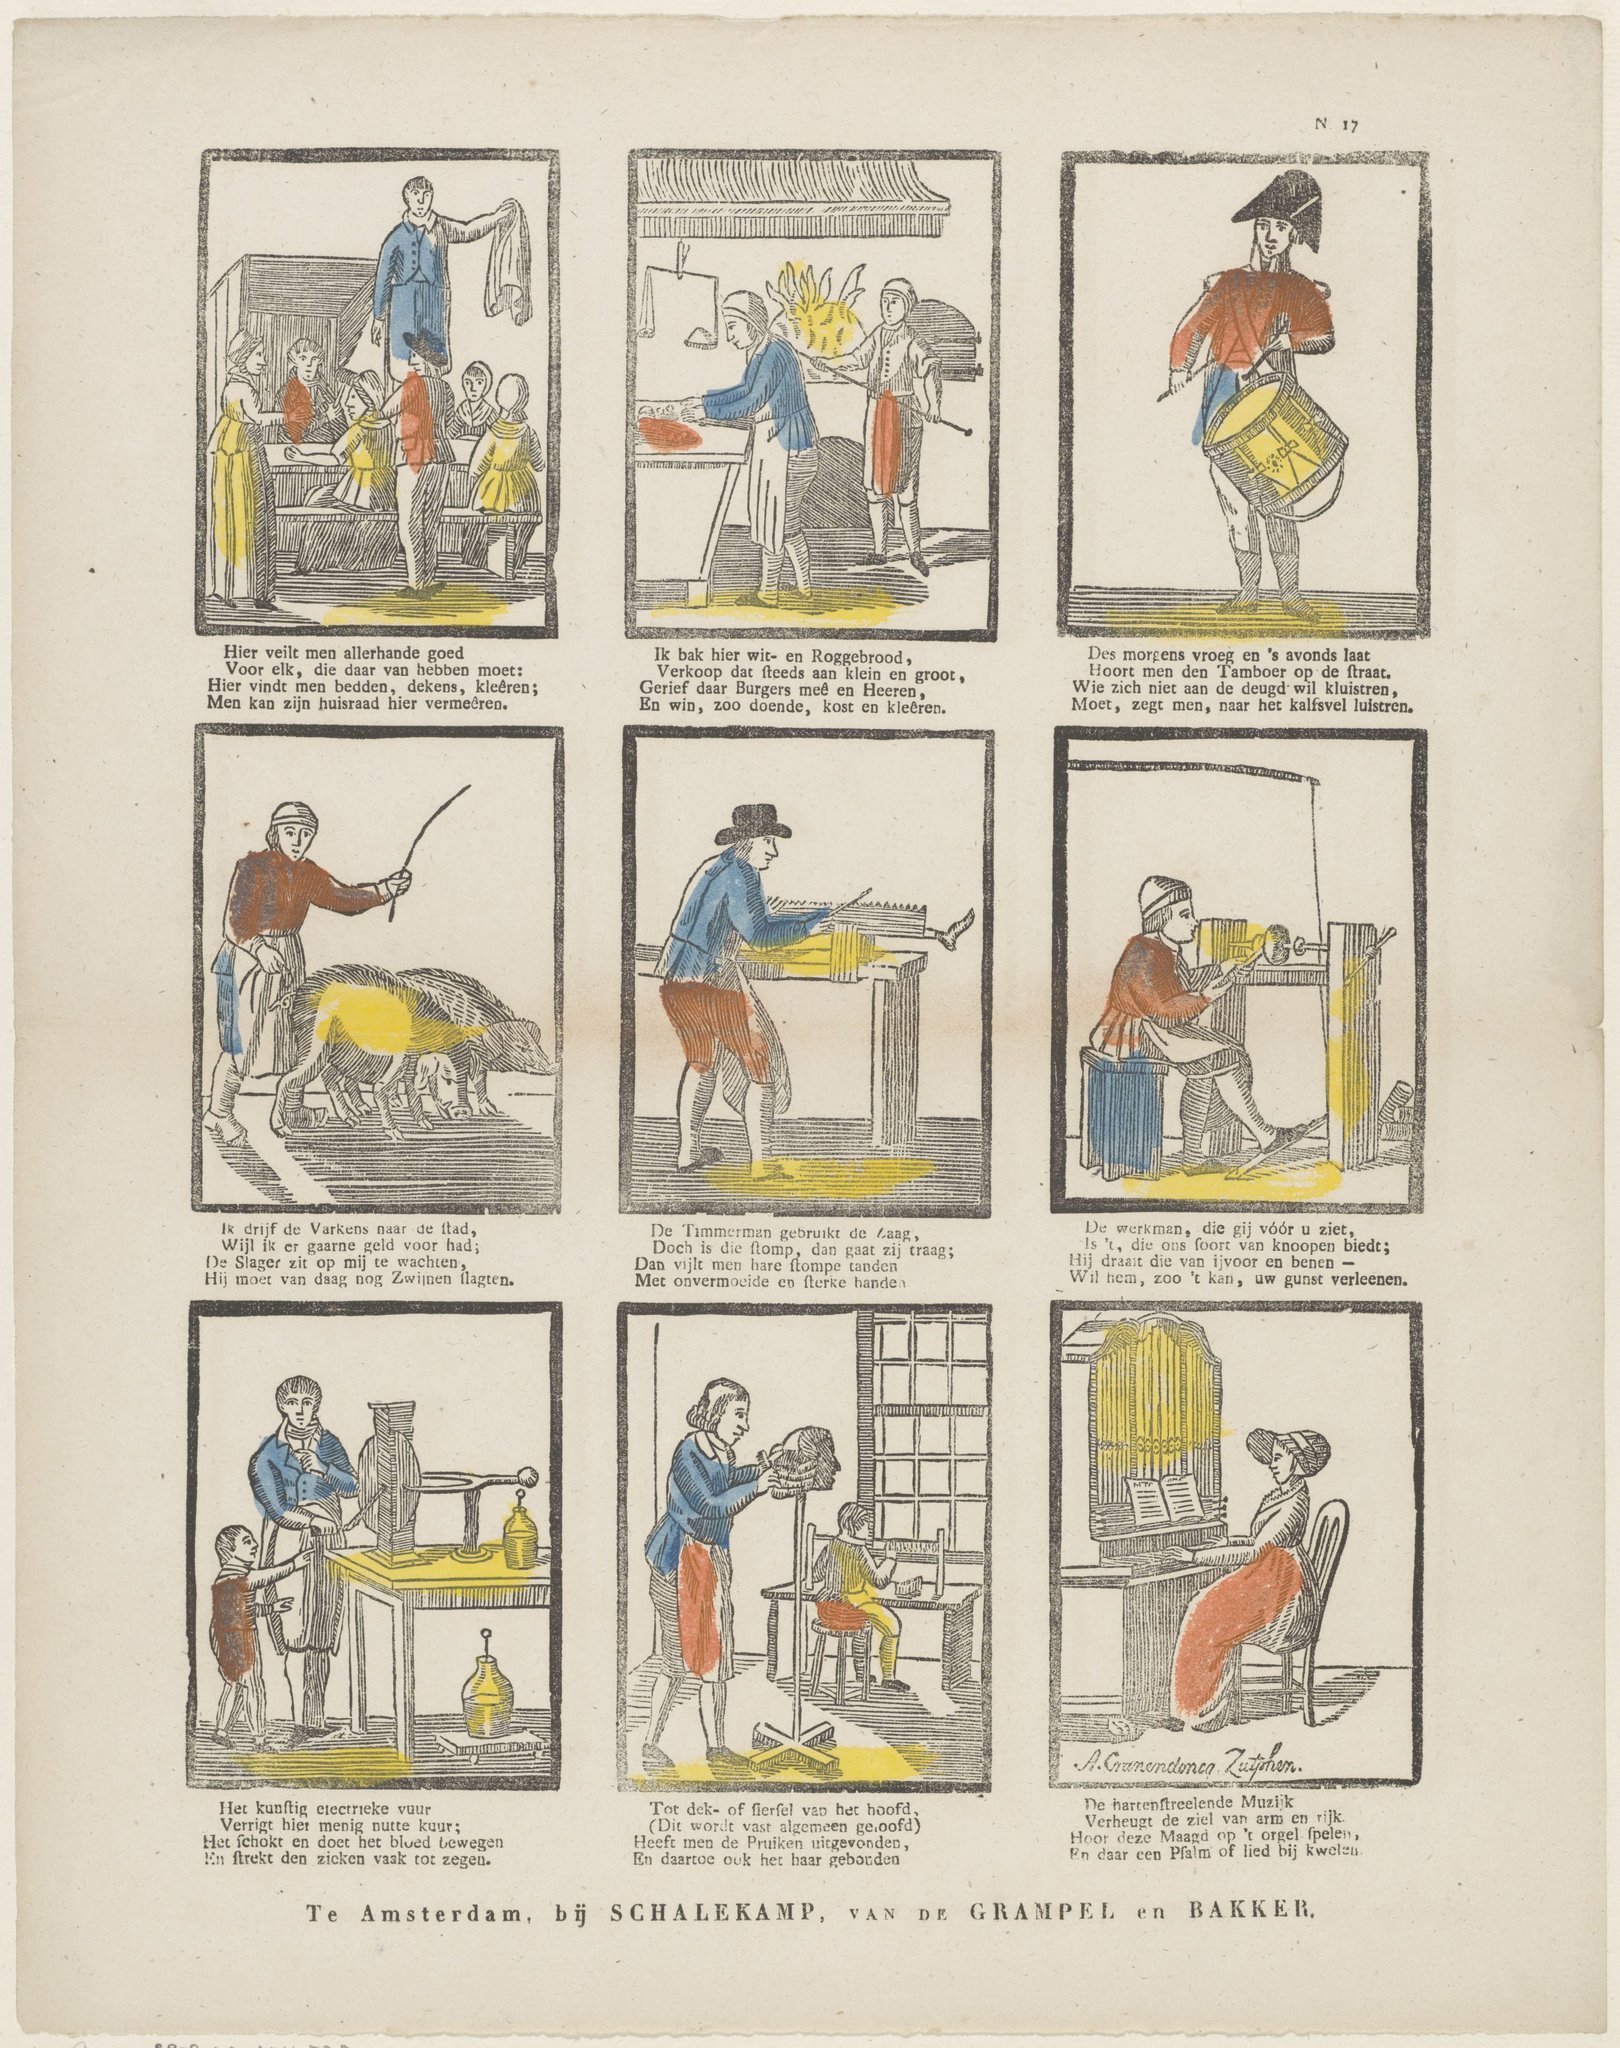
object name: print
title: Beroepen en ambachten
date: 1822-1849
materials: paper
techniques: colour, letterpress printing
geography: amsterdam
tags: wigmaker, 'perruquier', craft-production, skilled handiwork, farmers, working class, labourers, street-trader, crafts and industries, merchant, salesman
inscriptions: collector's mark: Lugt 2760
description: Blad met 9 voorstellingen van ambachtslieden en beroepen, zoals straatverkoper, tamboer, timmerman en pruikenmaker. Onder elke afbeelding een vierregelig vers. Genummerd rechtsboven: N. 17.